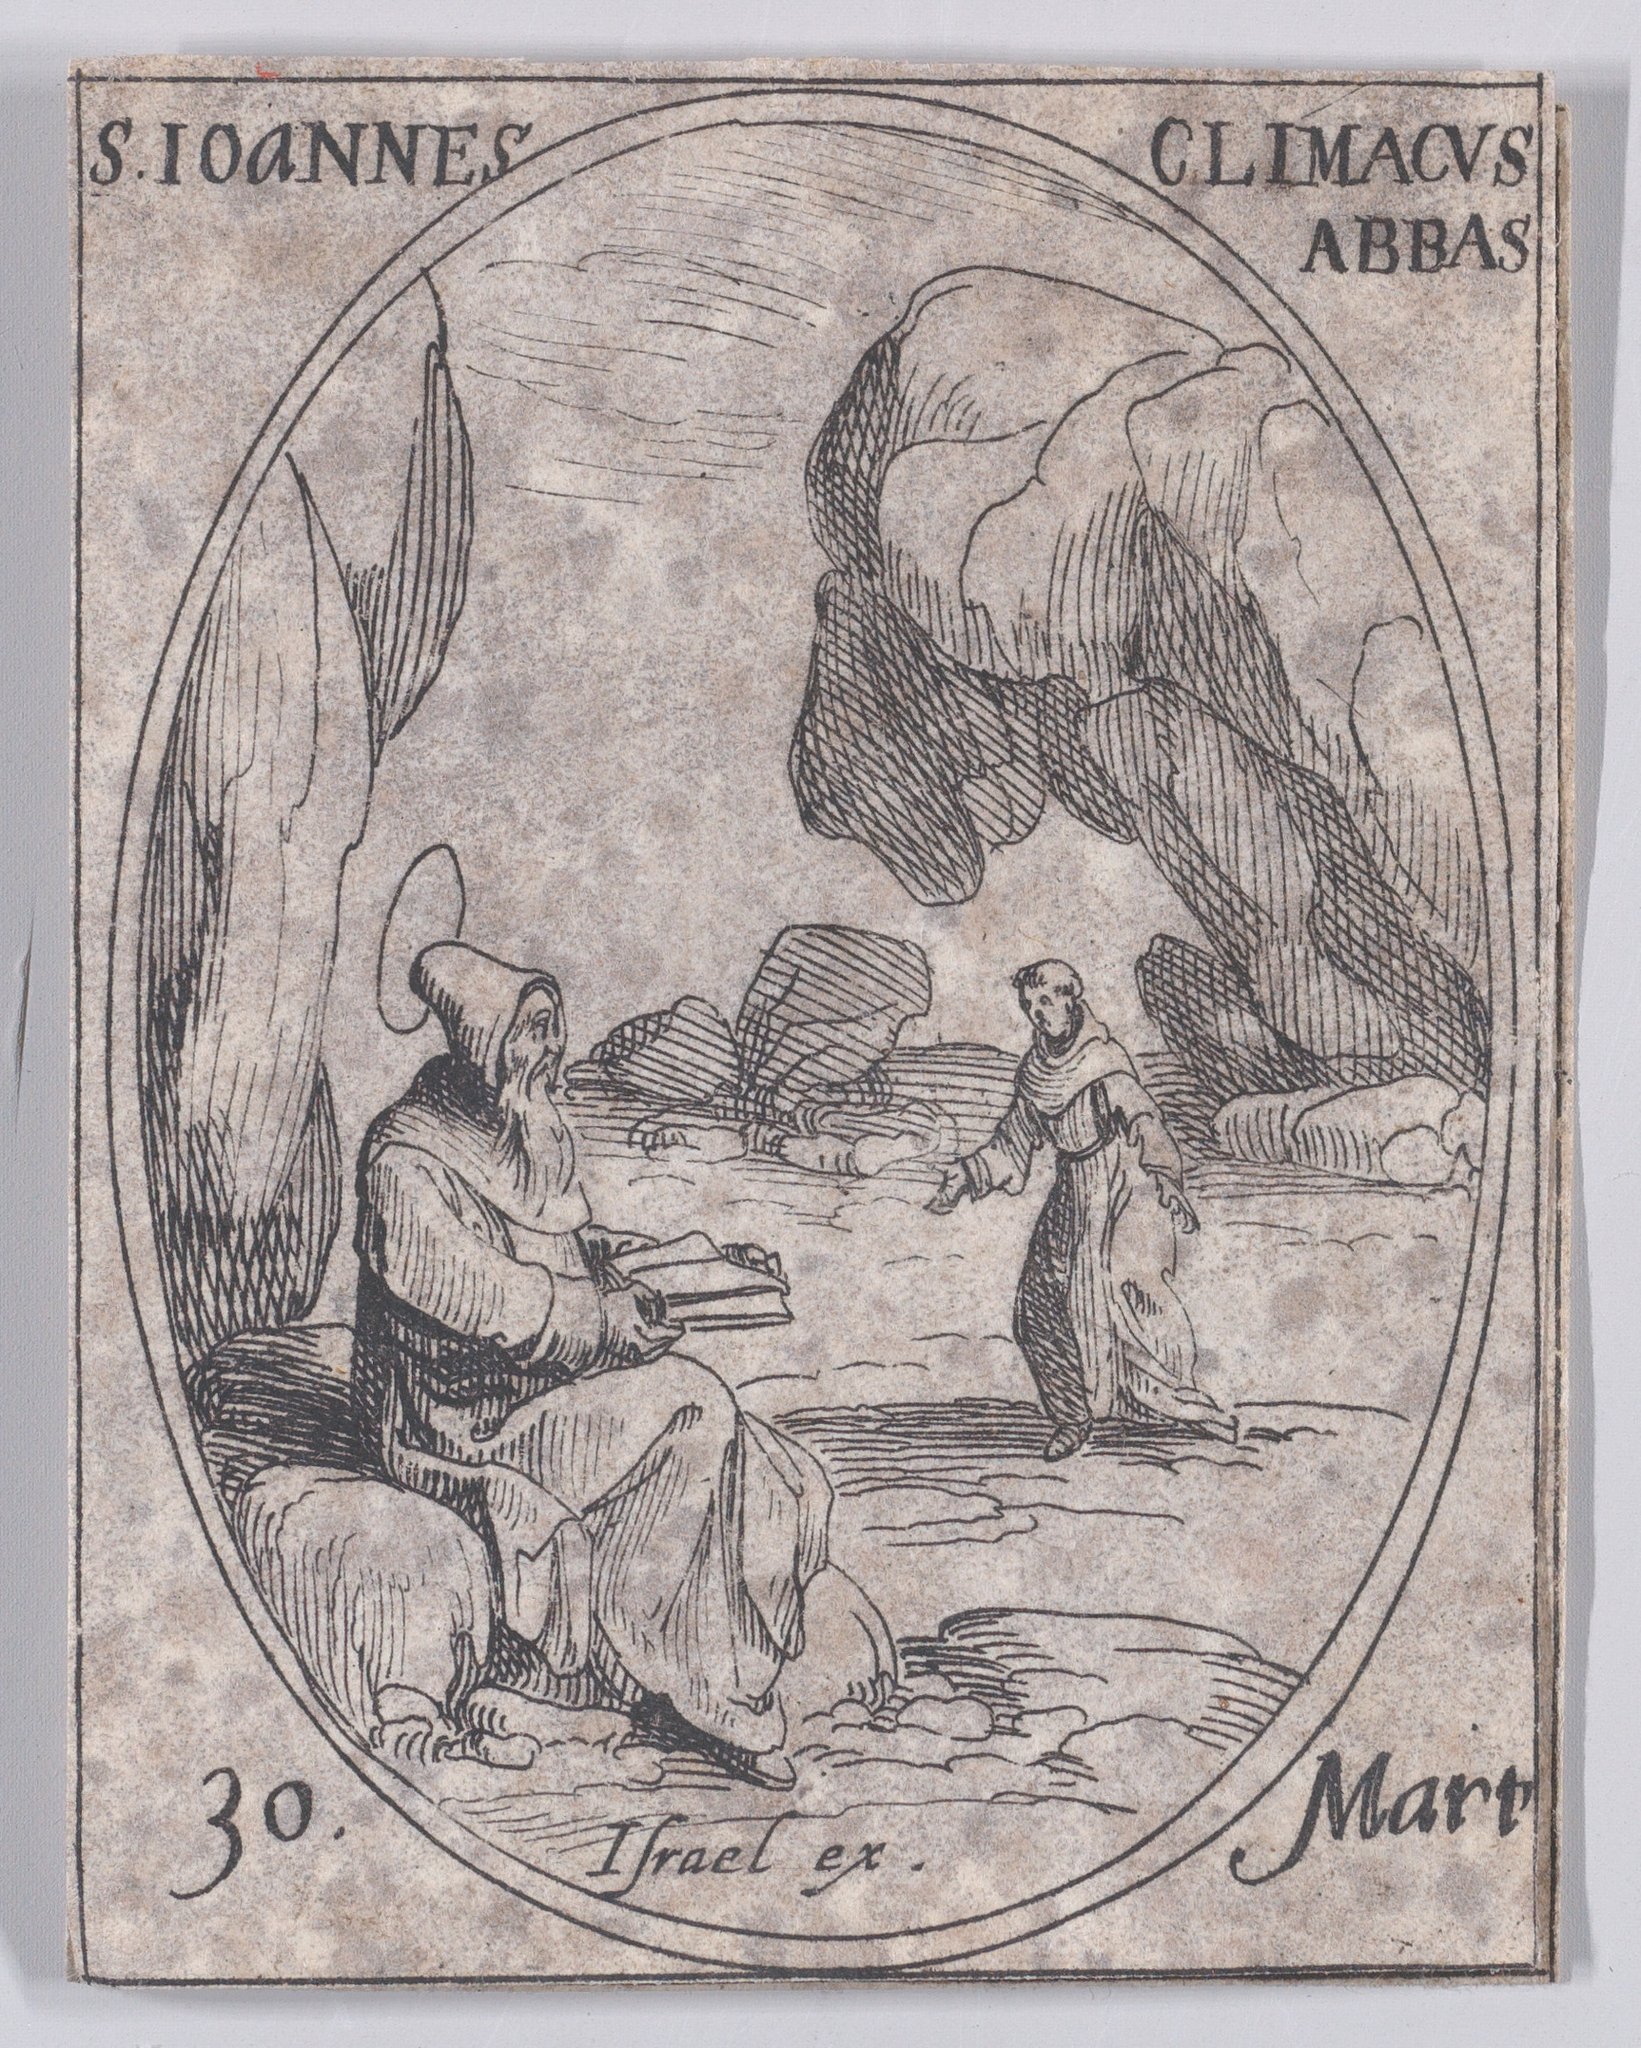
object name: print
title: S. Jean Climaque, abbé (St. John Climaticus, Abbot), March 30th, from "Les Images De Tous Les Saincts et Saintes de L'Année" (Images of All of the Saints and Religious Events of the Year)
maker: jacques callot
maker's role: artist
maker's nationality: french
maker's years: 1592-1635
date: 1636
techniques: etching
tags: men,saints